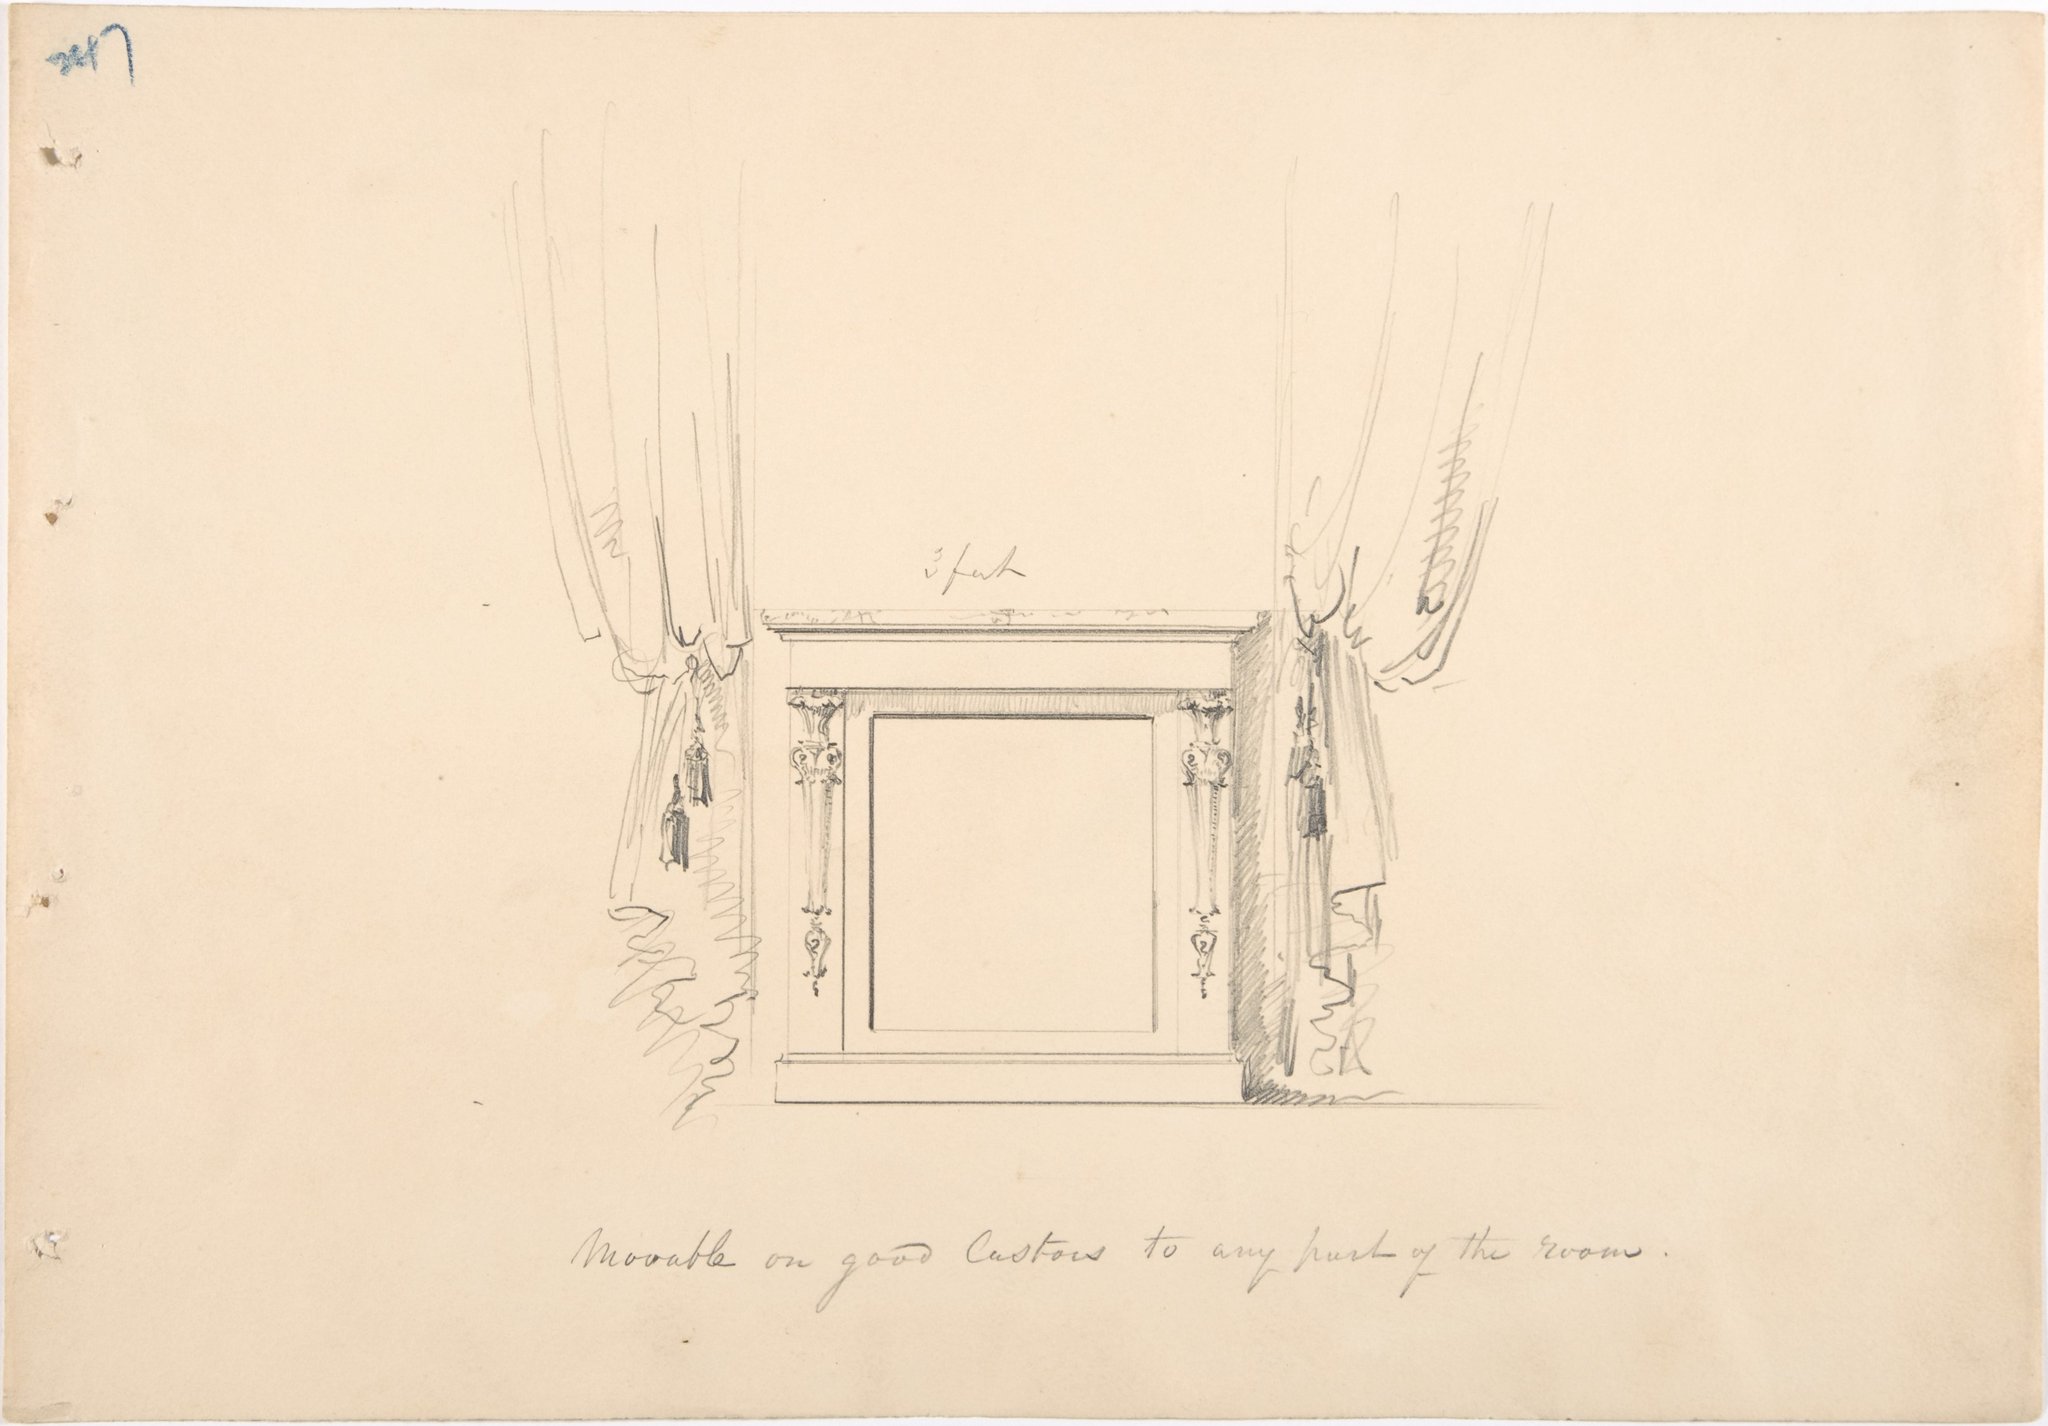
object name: drawing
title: Design for a Small Cabinet Between Curtains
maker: anonymous, british, 19th century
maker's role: artist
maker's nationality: british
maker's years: 1800-1900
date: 1801-1833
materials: graphite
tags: cabinets